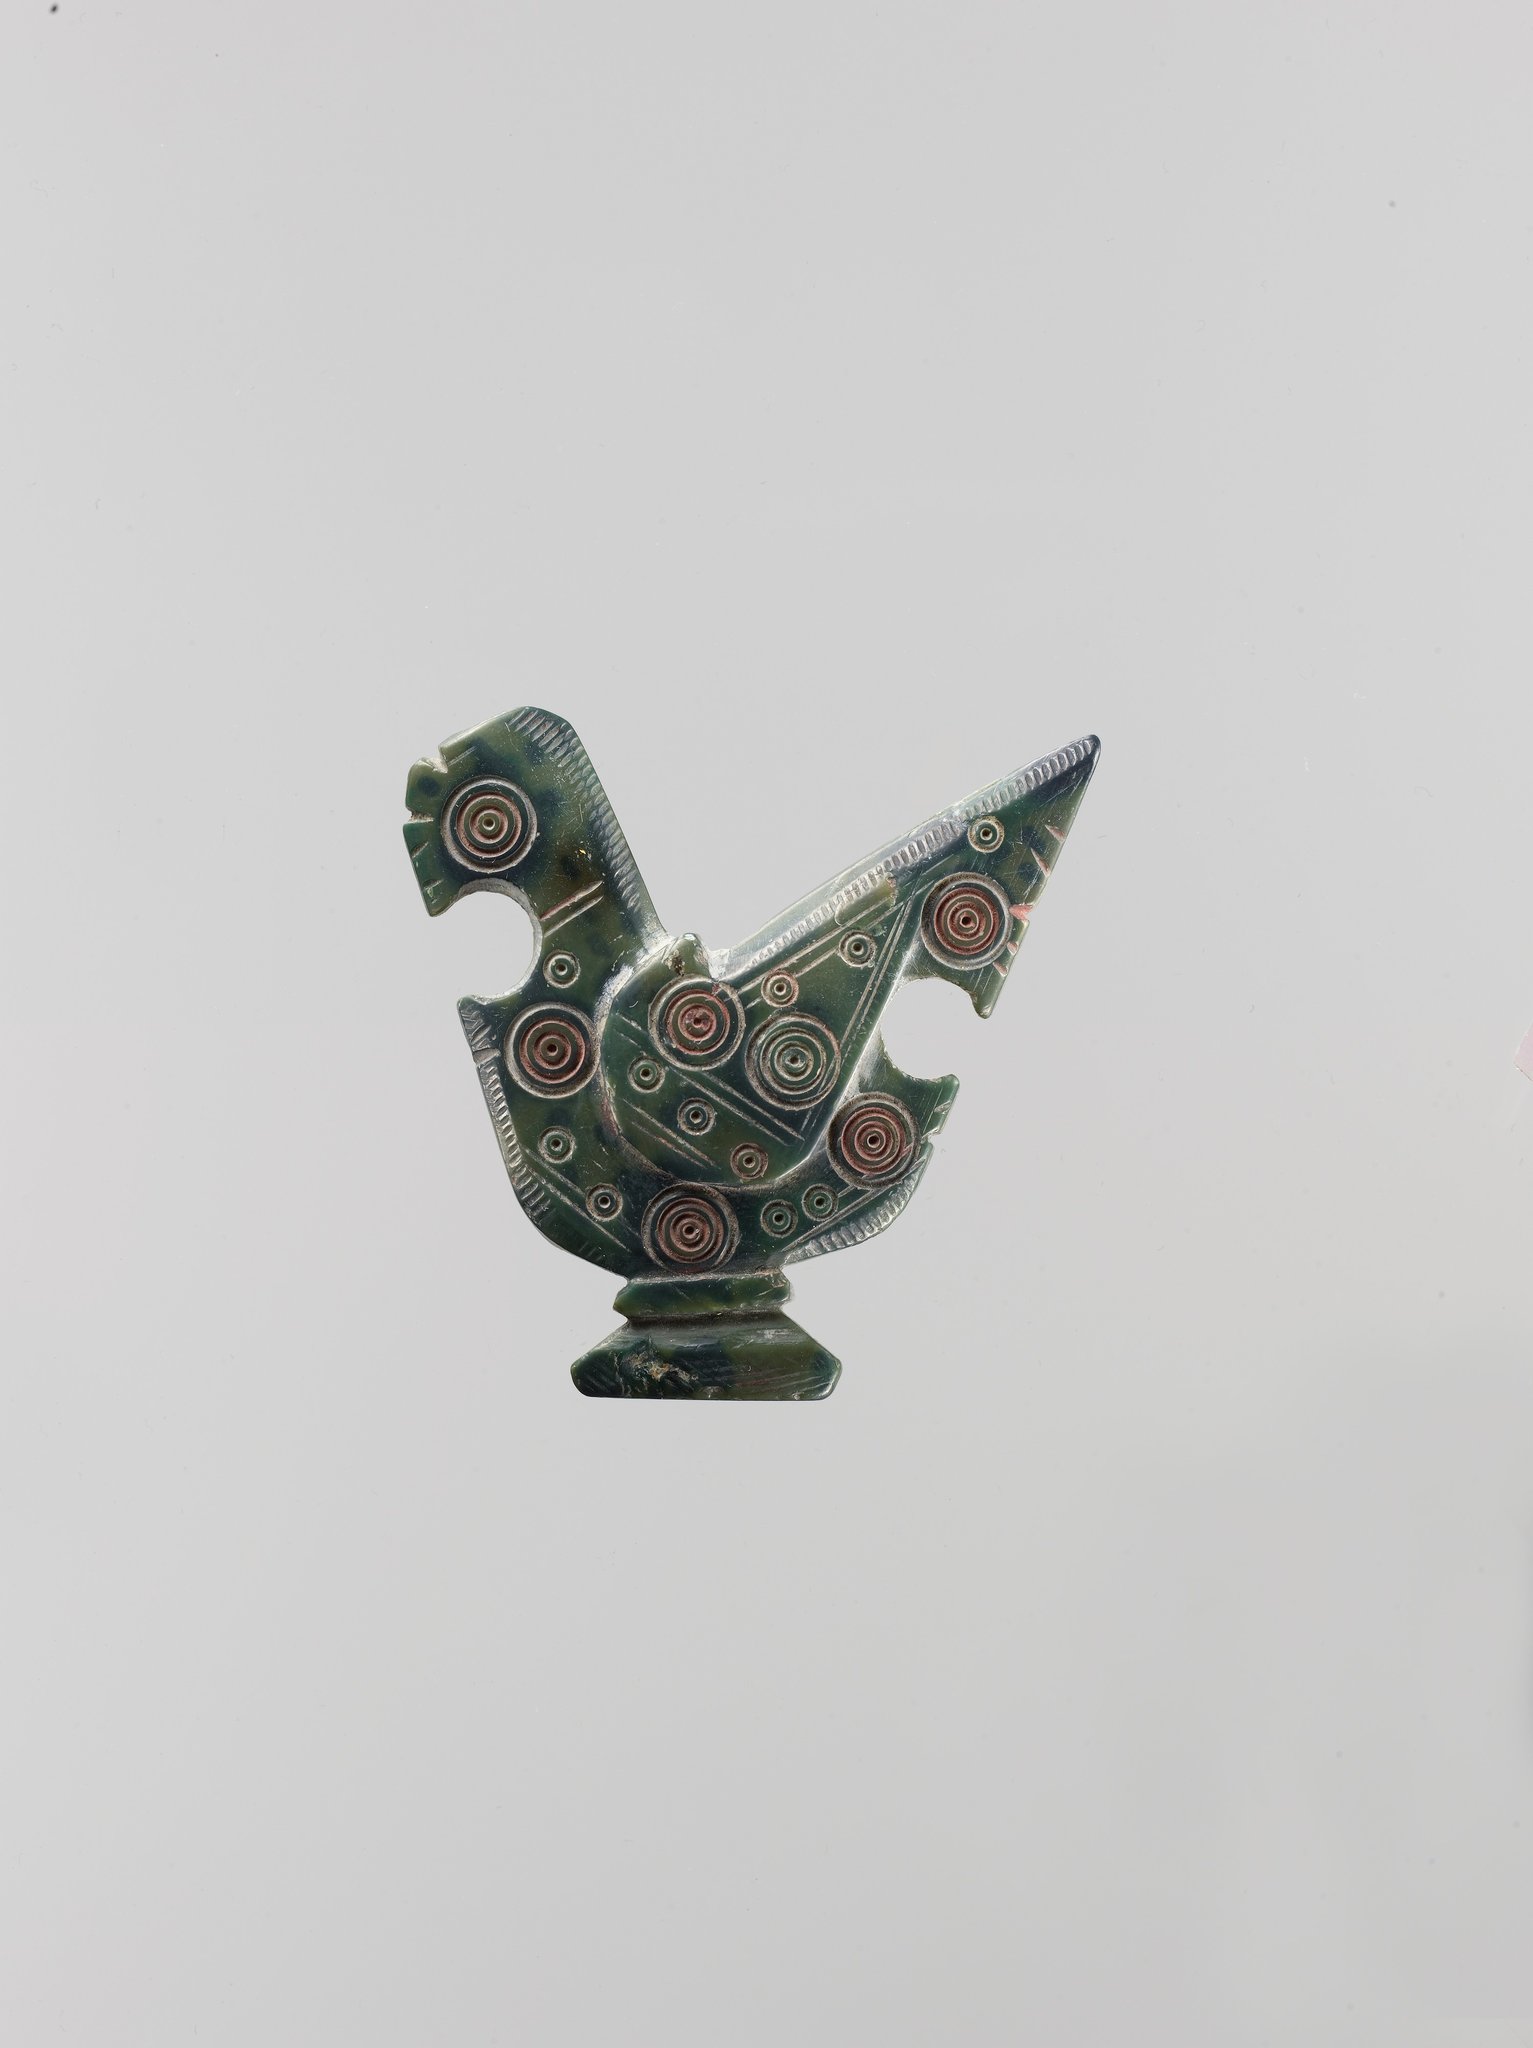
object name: kohl flask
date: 901-1200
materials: stone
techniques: carving, incising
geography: iran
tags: birds